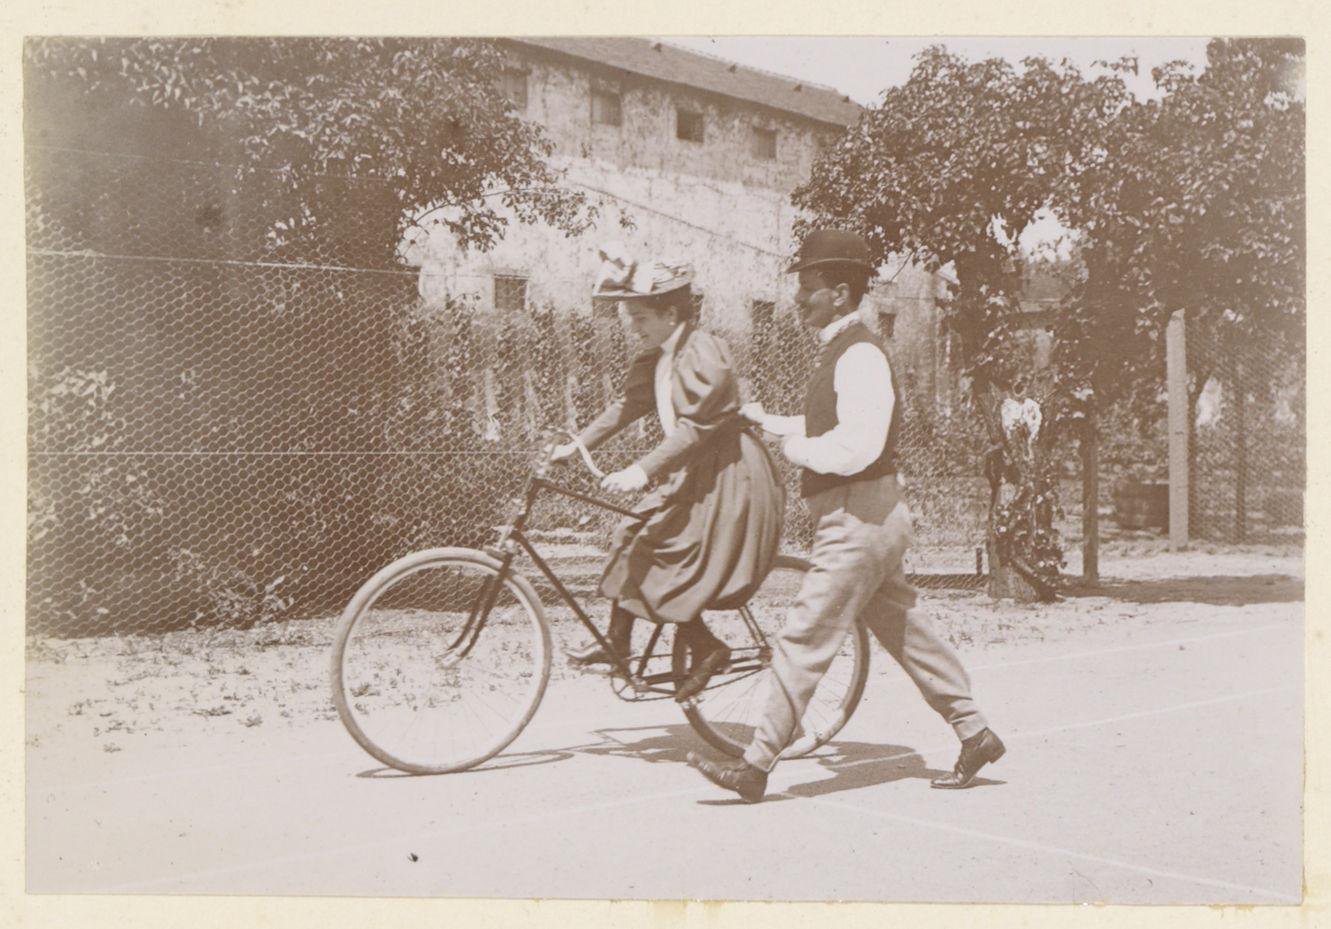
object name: photograph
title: Man leert vrouw fietsen, vermoedelijk in Frankrijk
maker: Anonymous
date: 1900-1910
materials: paper, photographic support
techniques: daylight paper print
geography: france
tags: riding, cycling (recreation), bicycle, france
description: Onderdeel van Fotoalbum van een Franse amateurfotograaf met opnames van een familie, distilleerderij Delizy & Doistau Fils, het leger en bezienswaardigheden in Frankrijk.